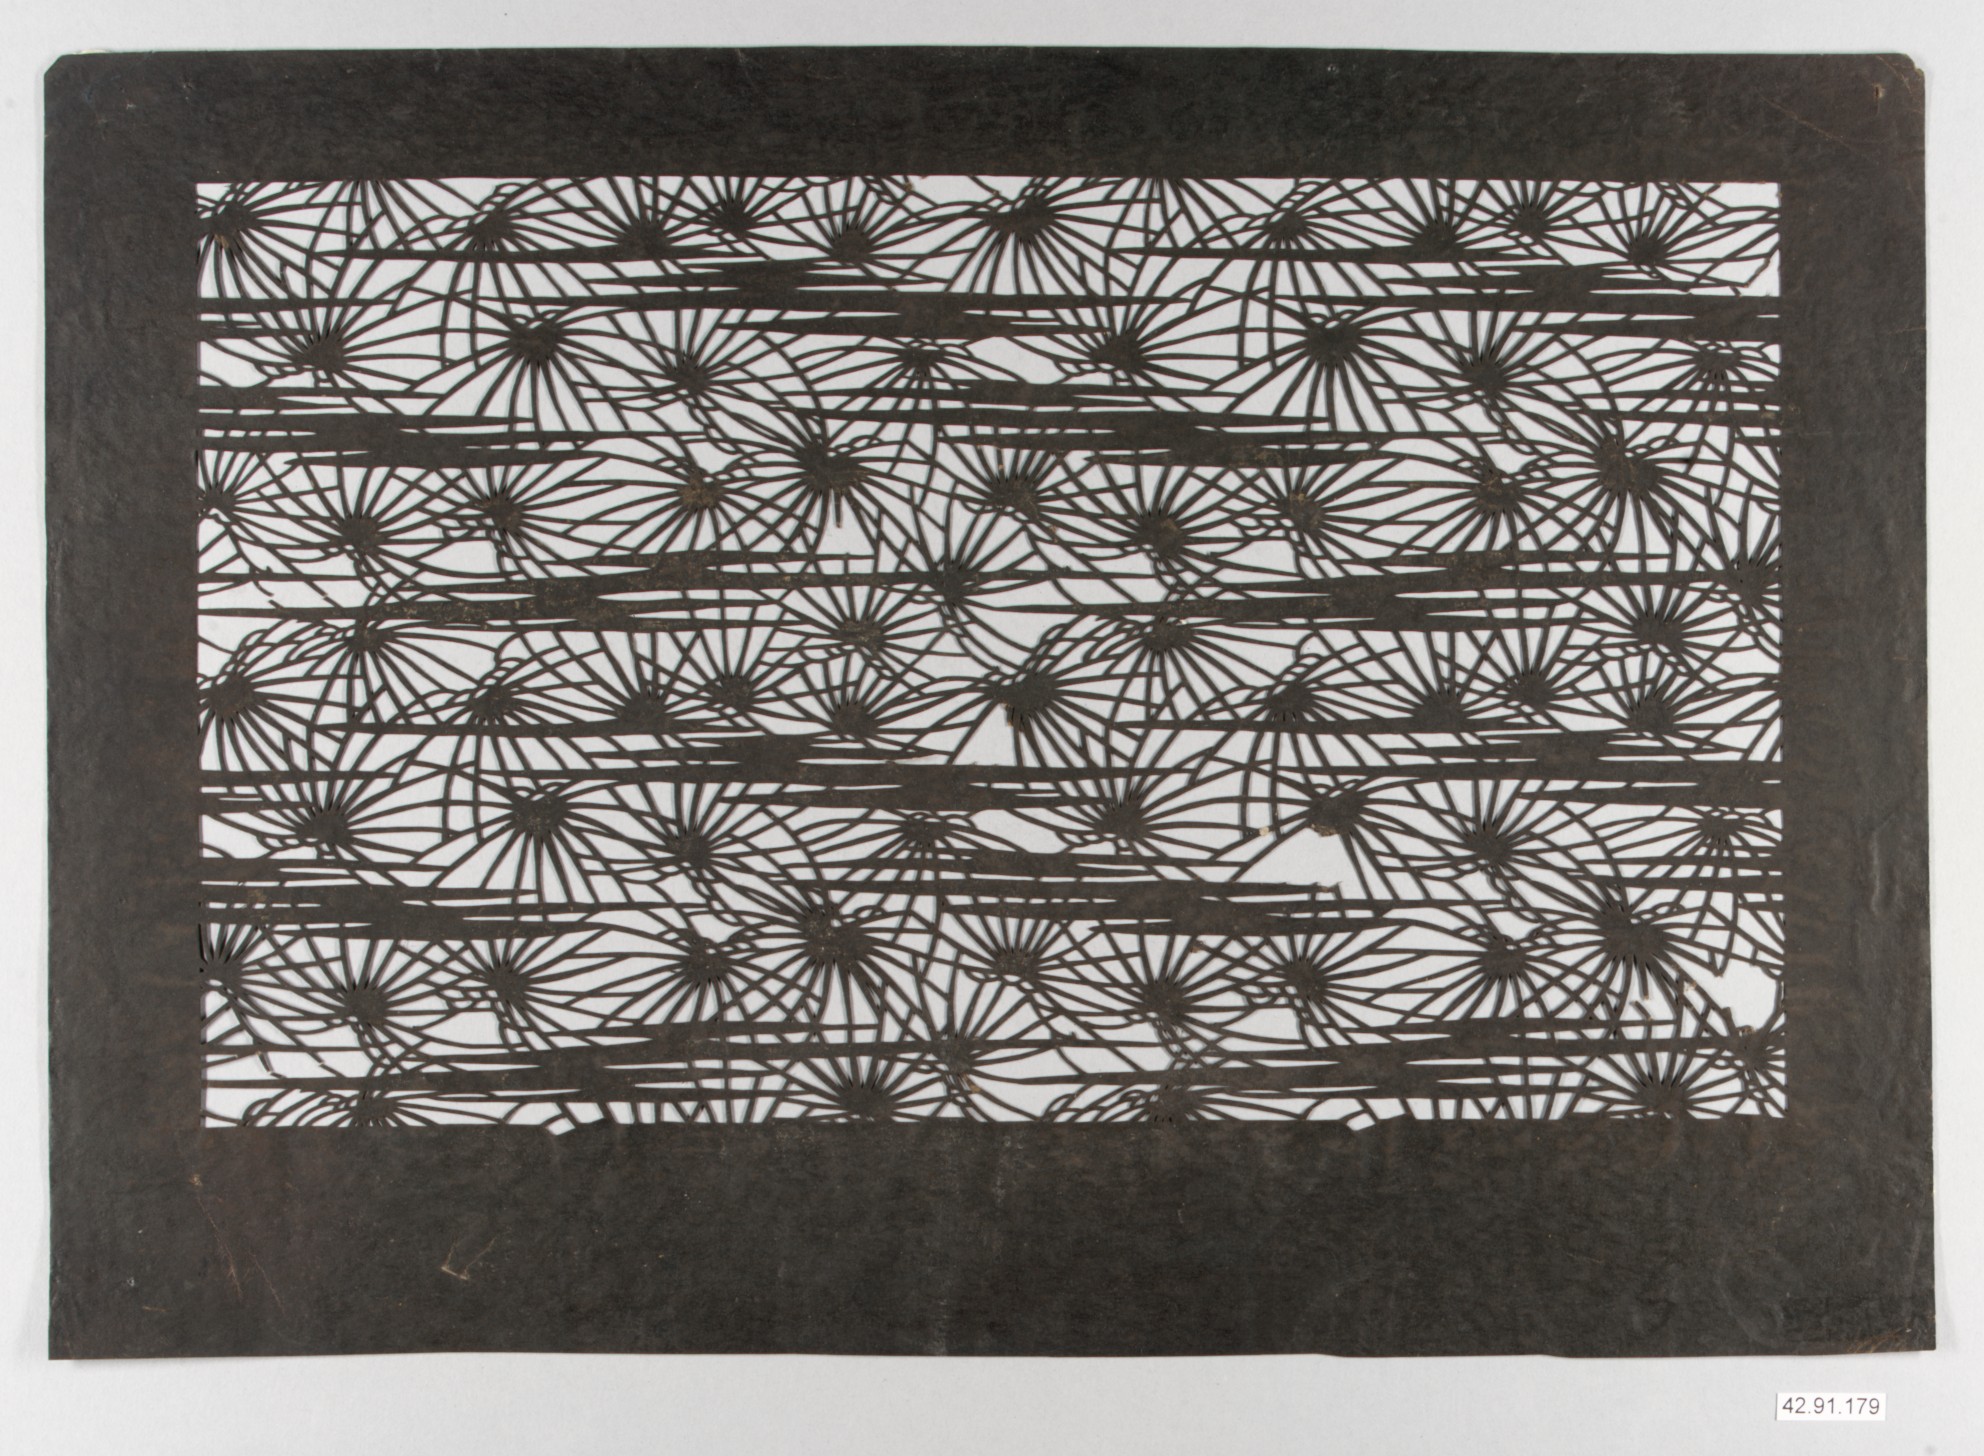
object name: stencil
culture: japanese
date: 1801-1900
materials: paper